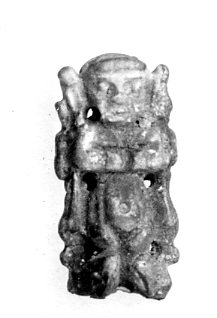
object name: amulet, pataikos on crocodile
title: Pataikos amulet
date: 664-332 BCE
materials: faience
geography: egypt